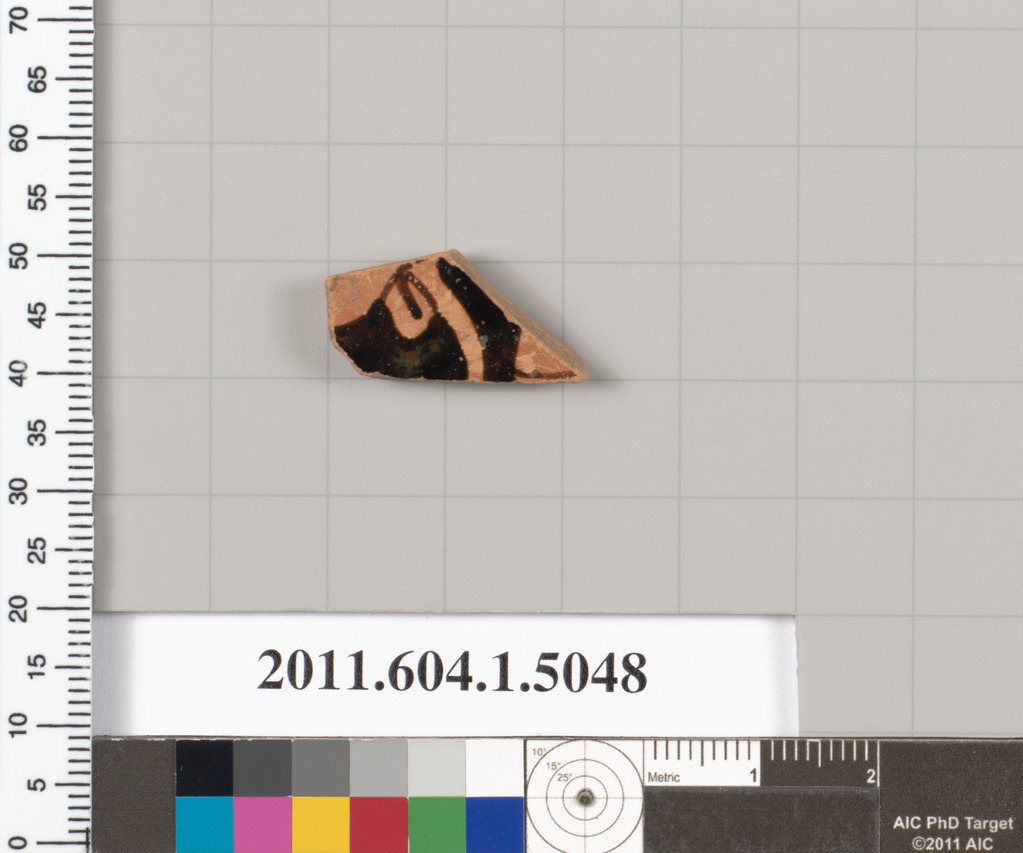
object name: kylix fragment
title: Terracotta fragment of a kylix (drinking cup)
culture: greek, attic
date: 467-435 BCE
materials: terracotta